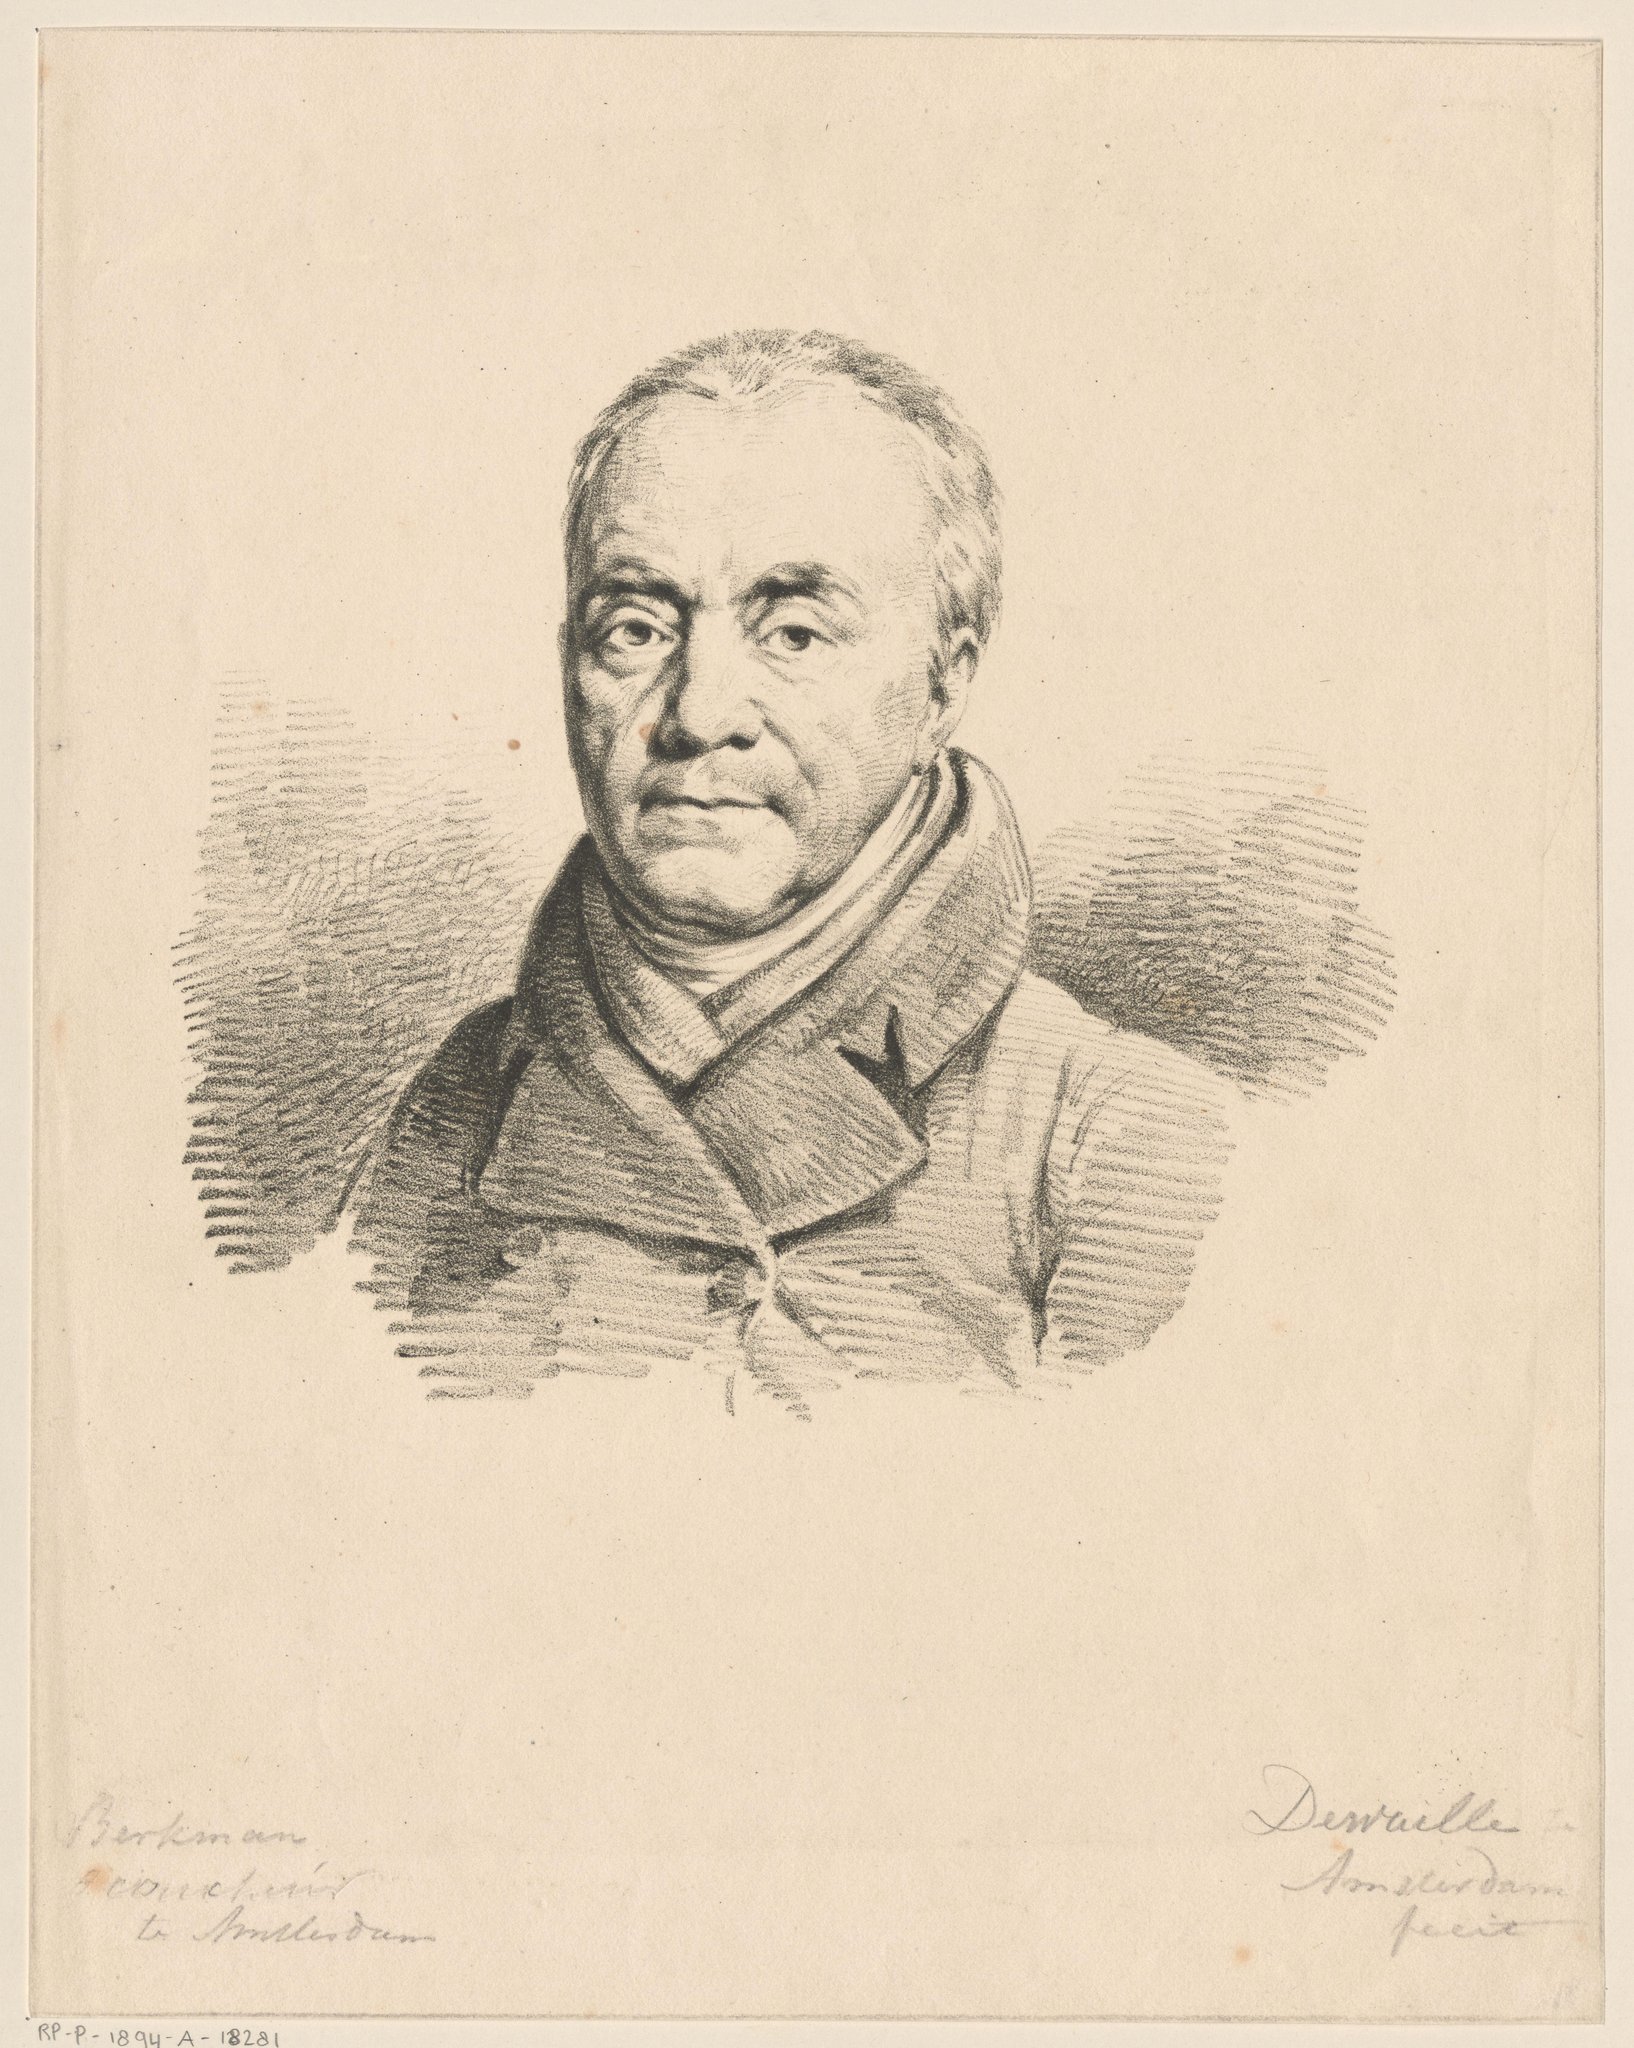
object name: print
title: Portret van Hendrik Berkman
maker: jean augustin daiwaille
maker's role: draughtsman, print maker, printer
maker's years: 1786-1850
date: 1819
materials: paper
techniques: lithograph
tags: amsterdam, historical persons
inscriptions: collector's mark: Lugt 2228